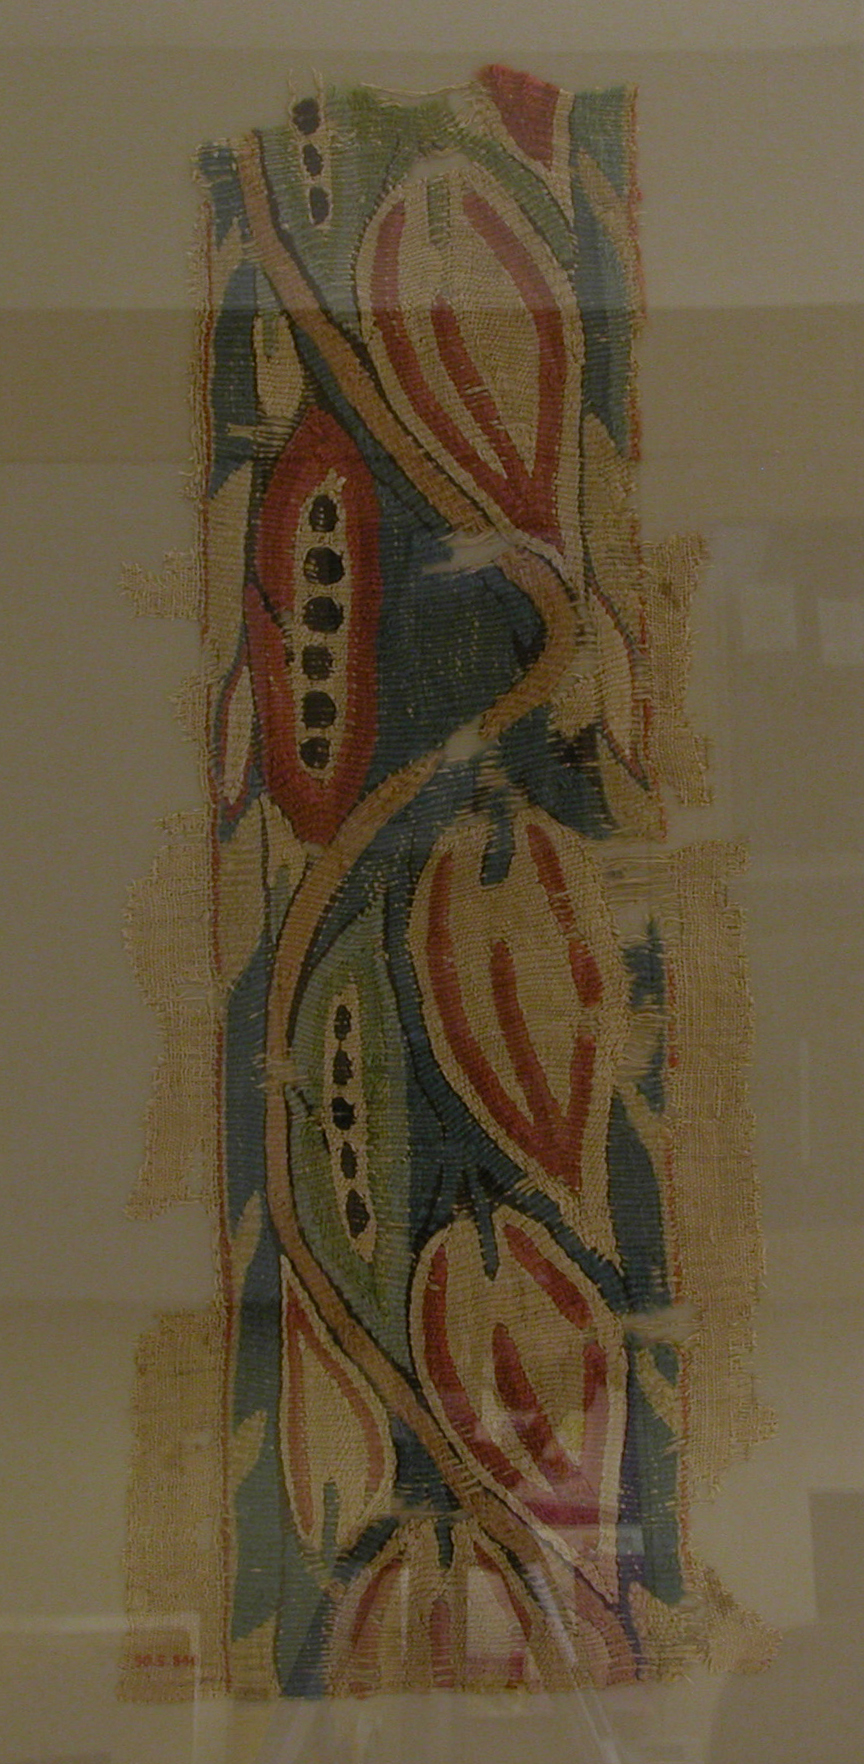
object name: textile fragment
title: Fragments of a Hanging with a Lotus-Motif Band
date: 401-600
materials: linen, wool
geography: egypt